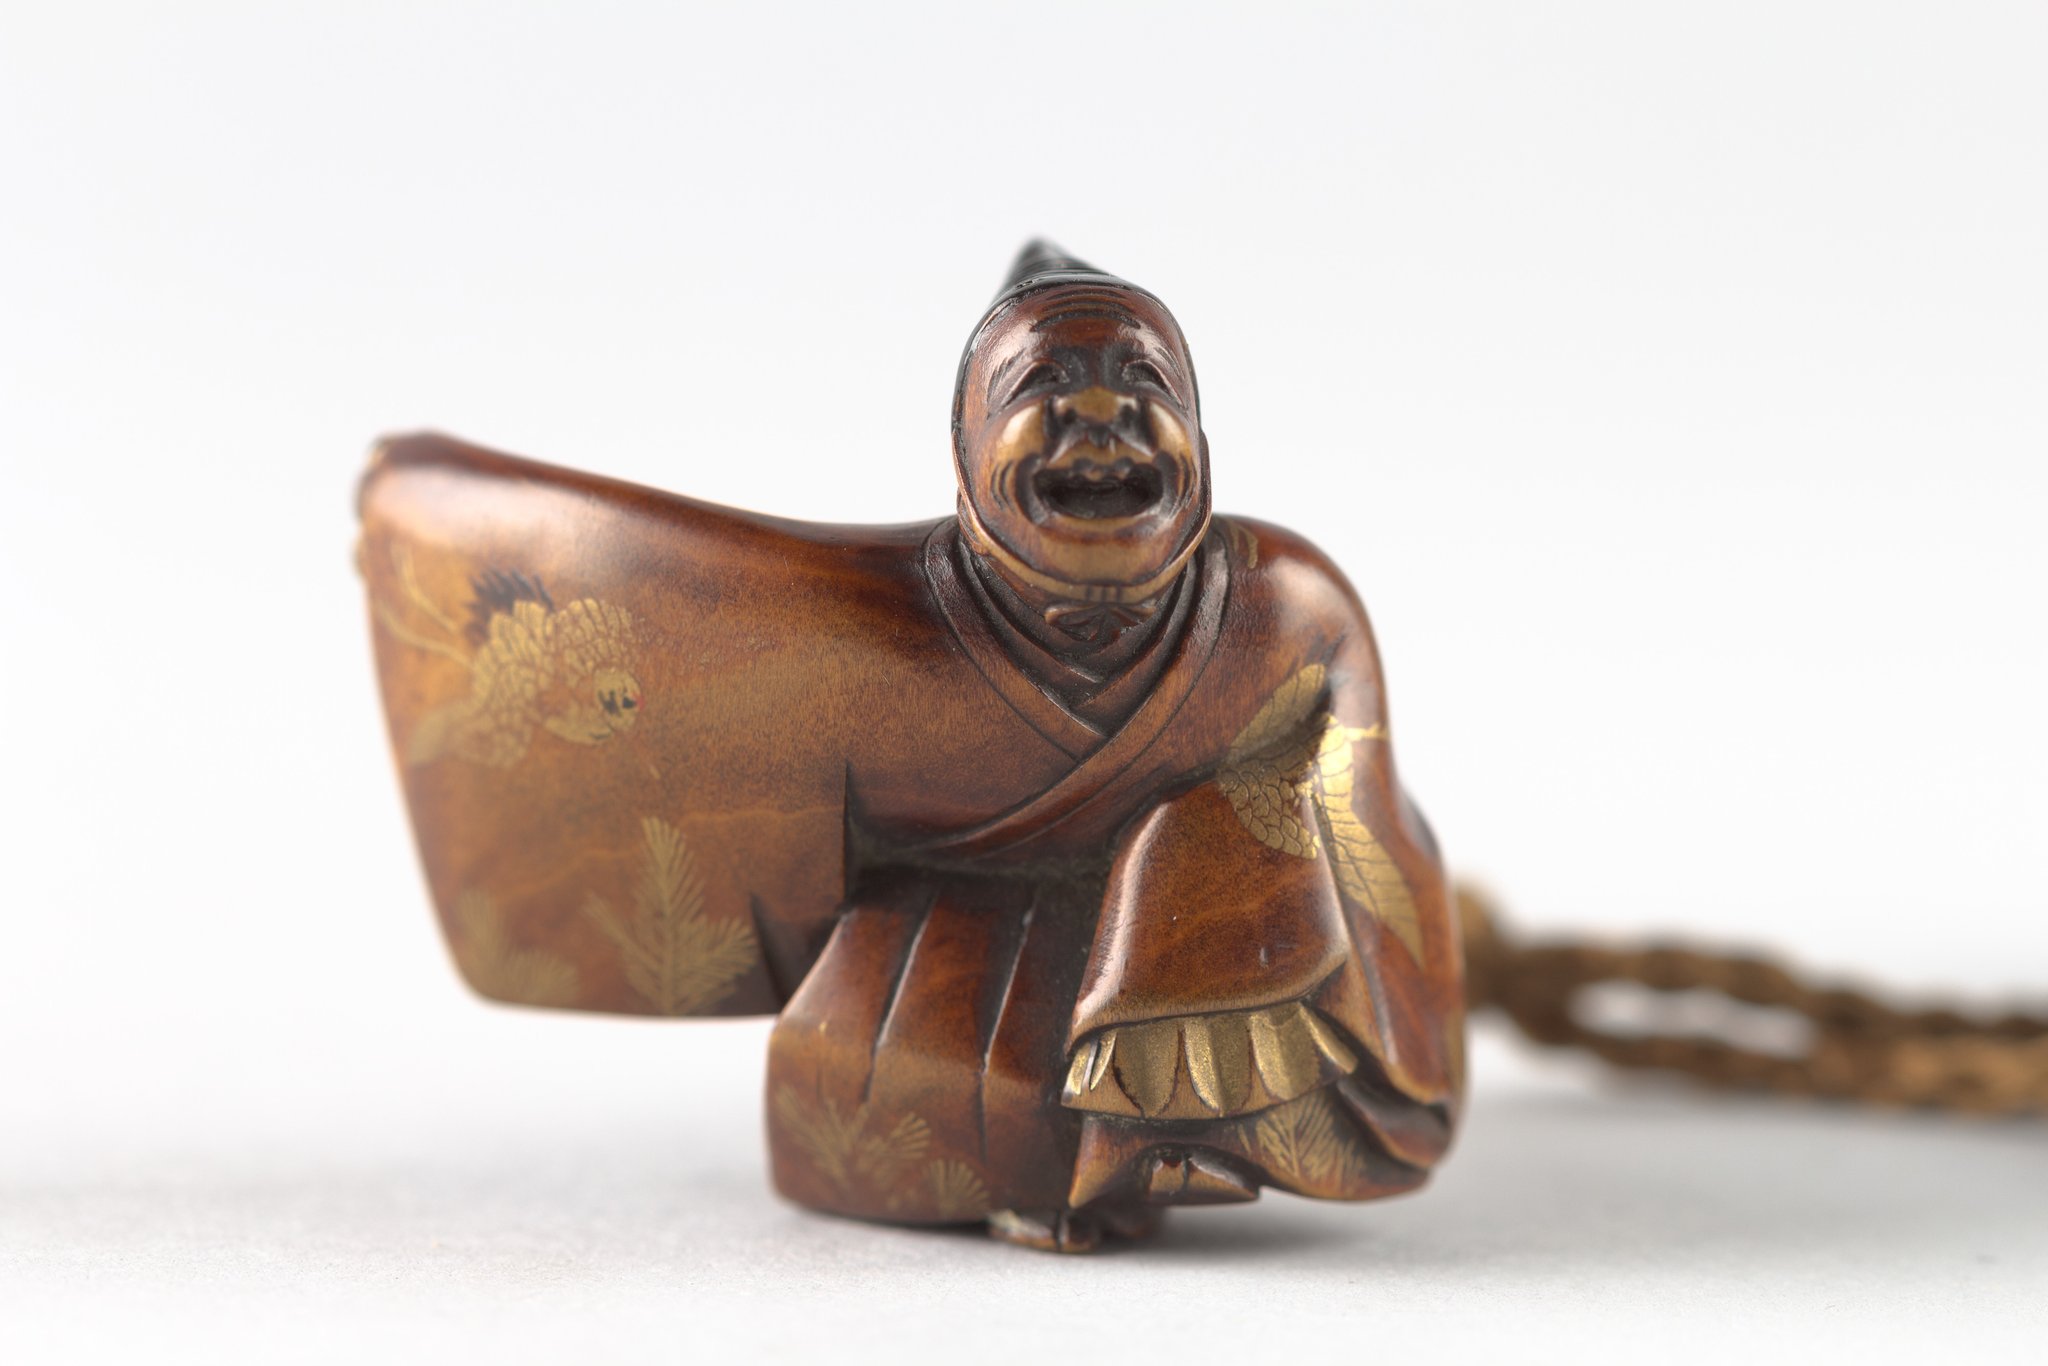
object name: netsuke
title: Netsuke of Sambaso Dancer with Bells and Fan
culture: japanese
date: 1801-1900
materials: wood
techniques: lacquer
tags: men,dancers